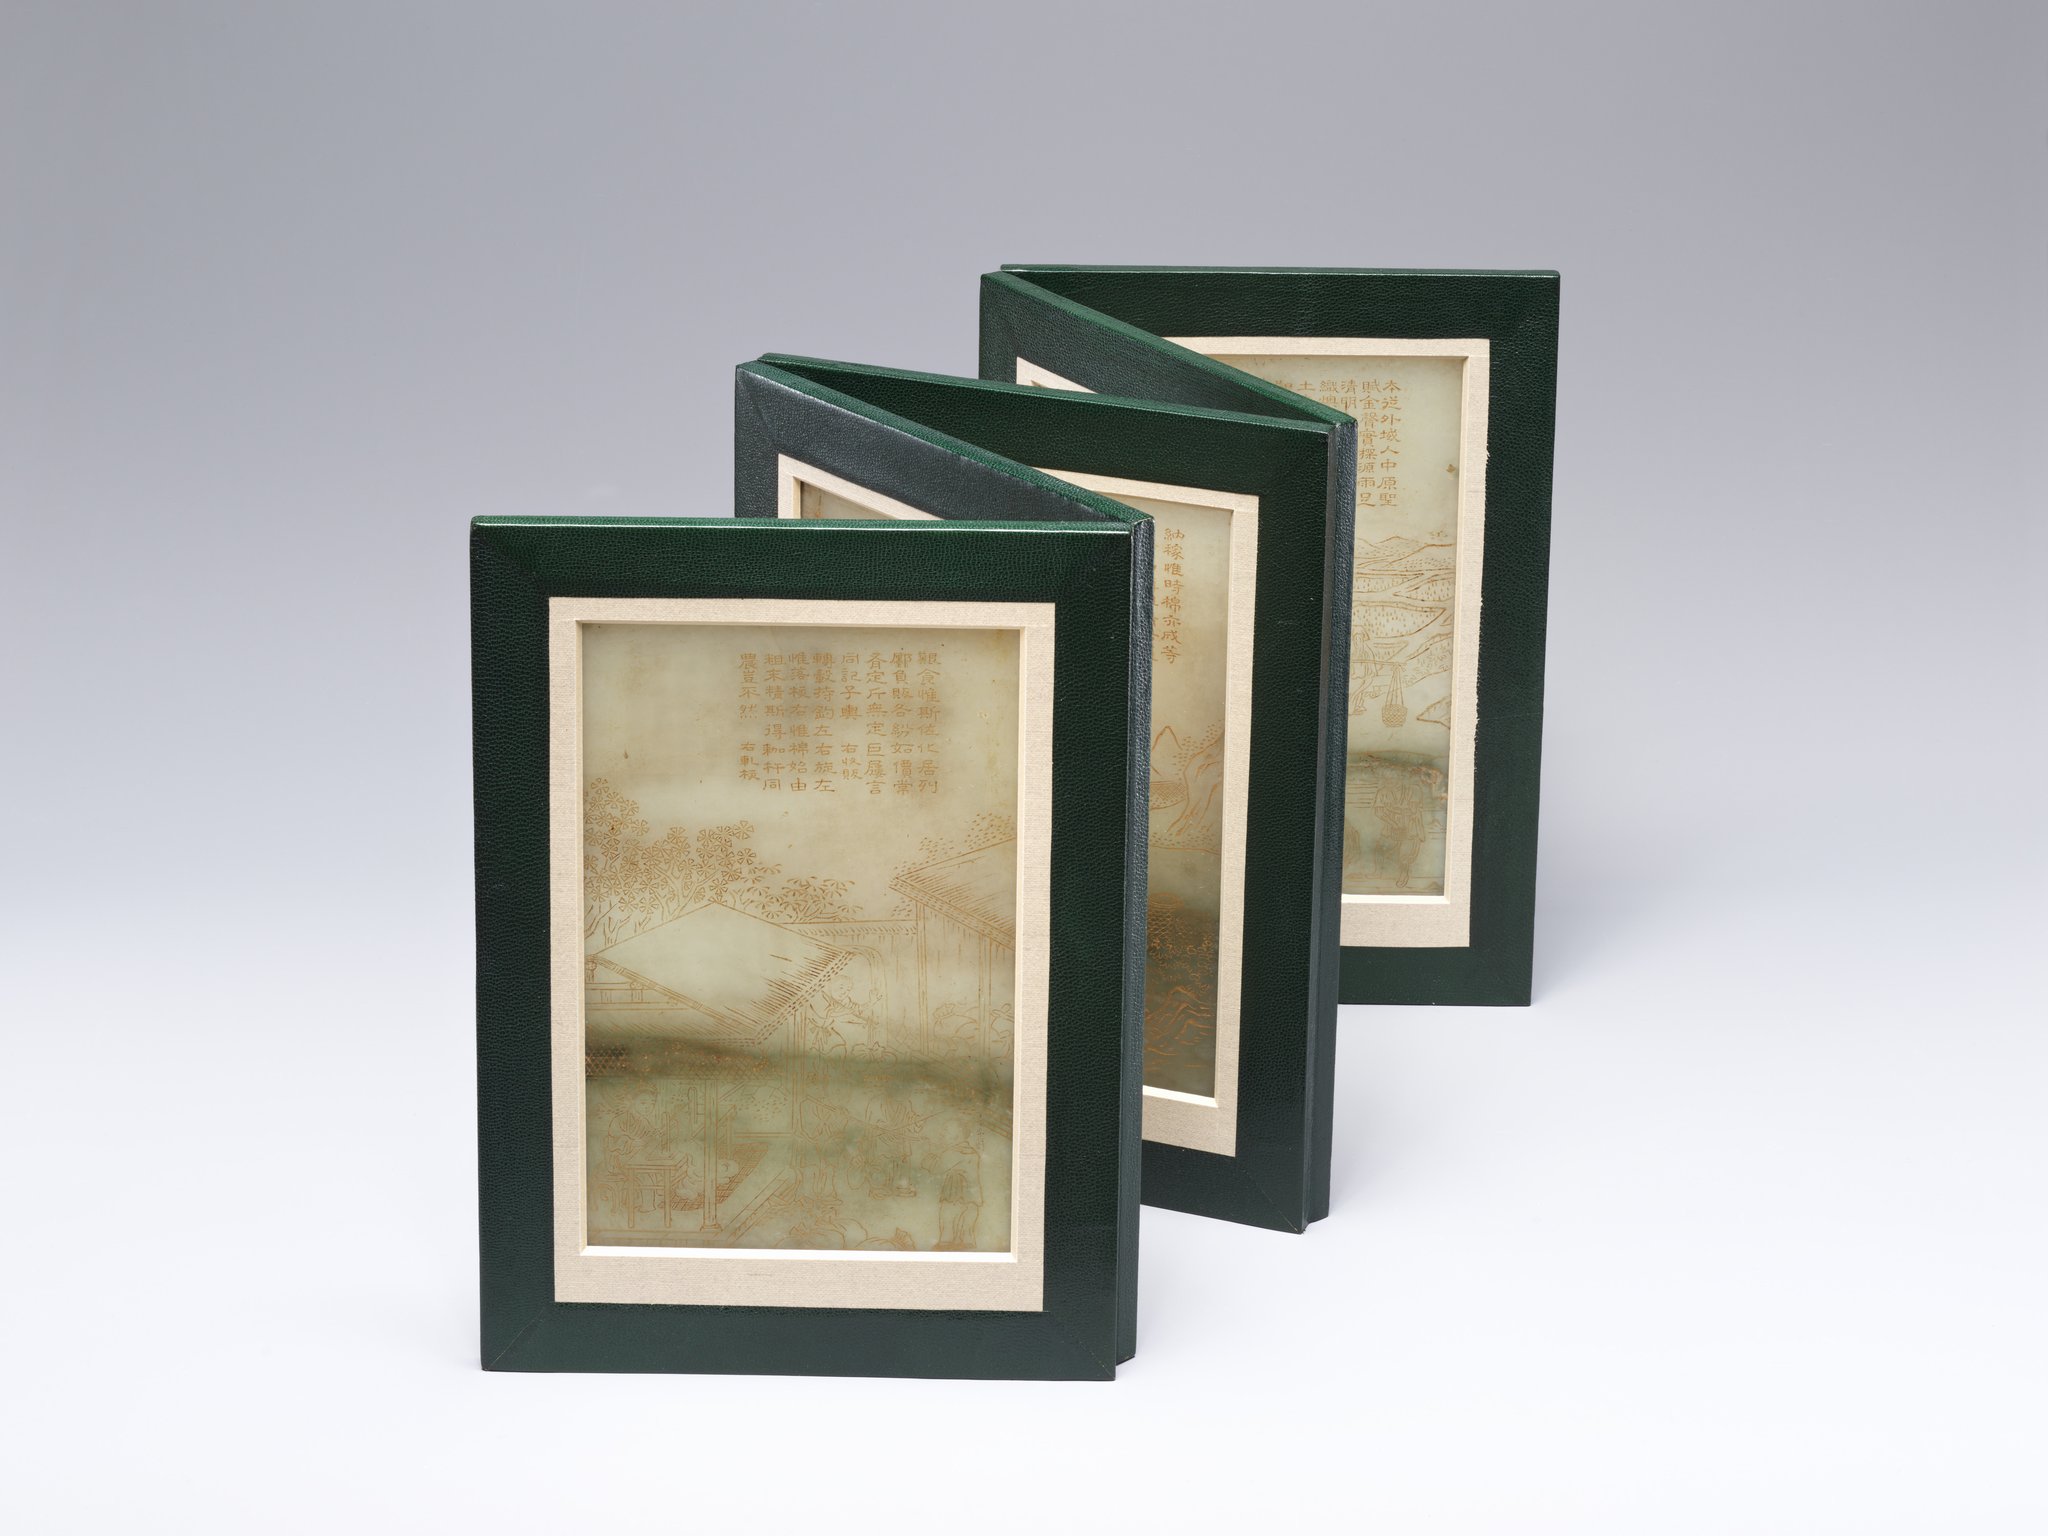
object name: book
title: Album of Illustrated Cotton Production and poems composed by the Qianlong Emperor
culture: chinese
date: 1767-1800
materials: jade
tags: industry